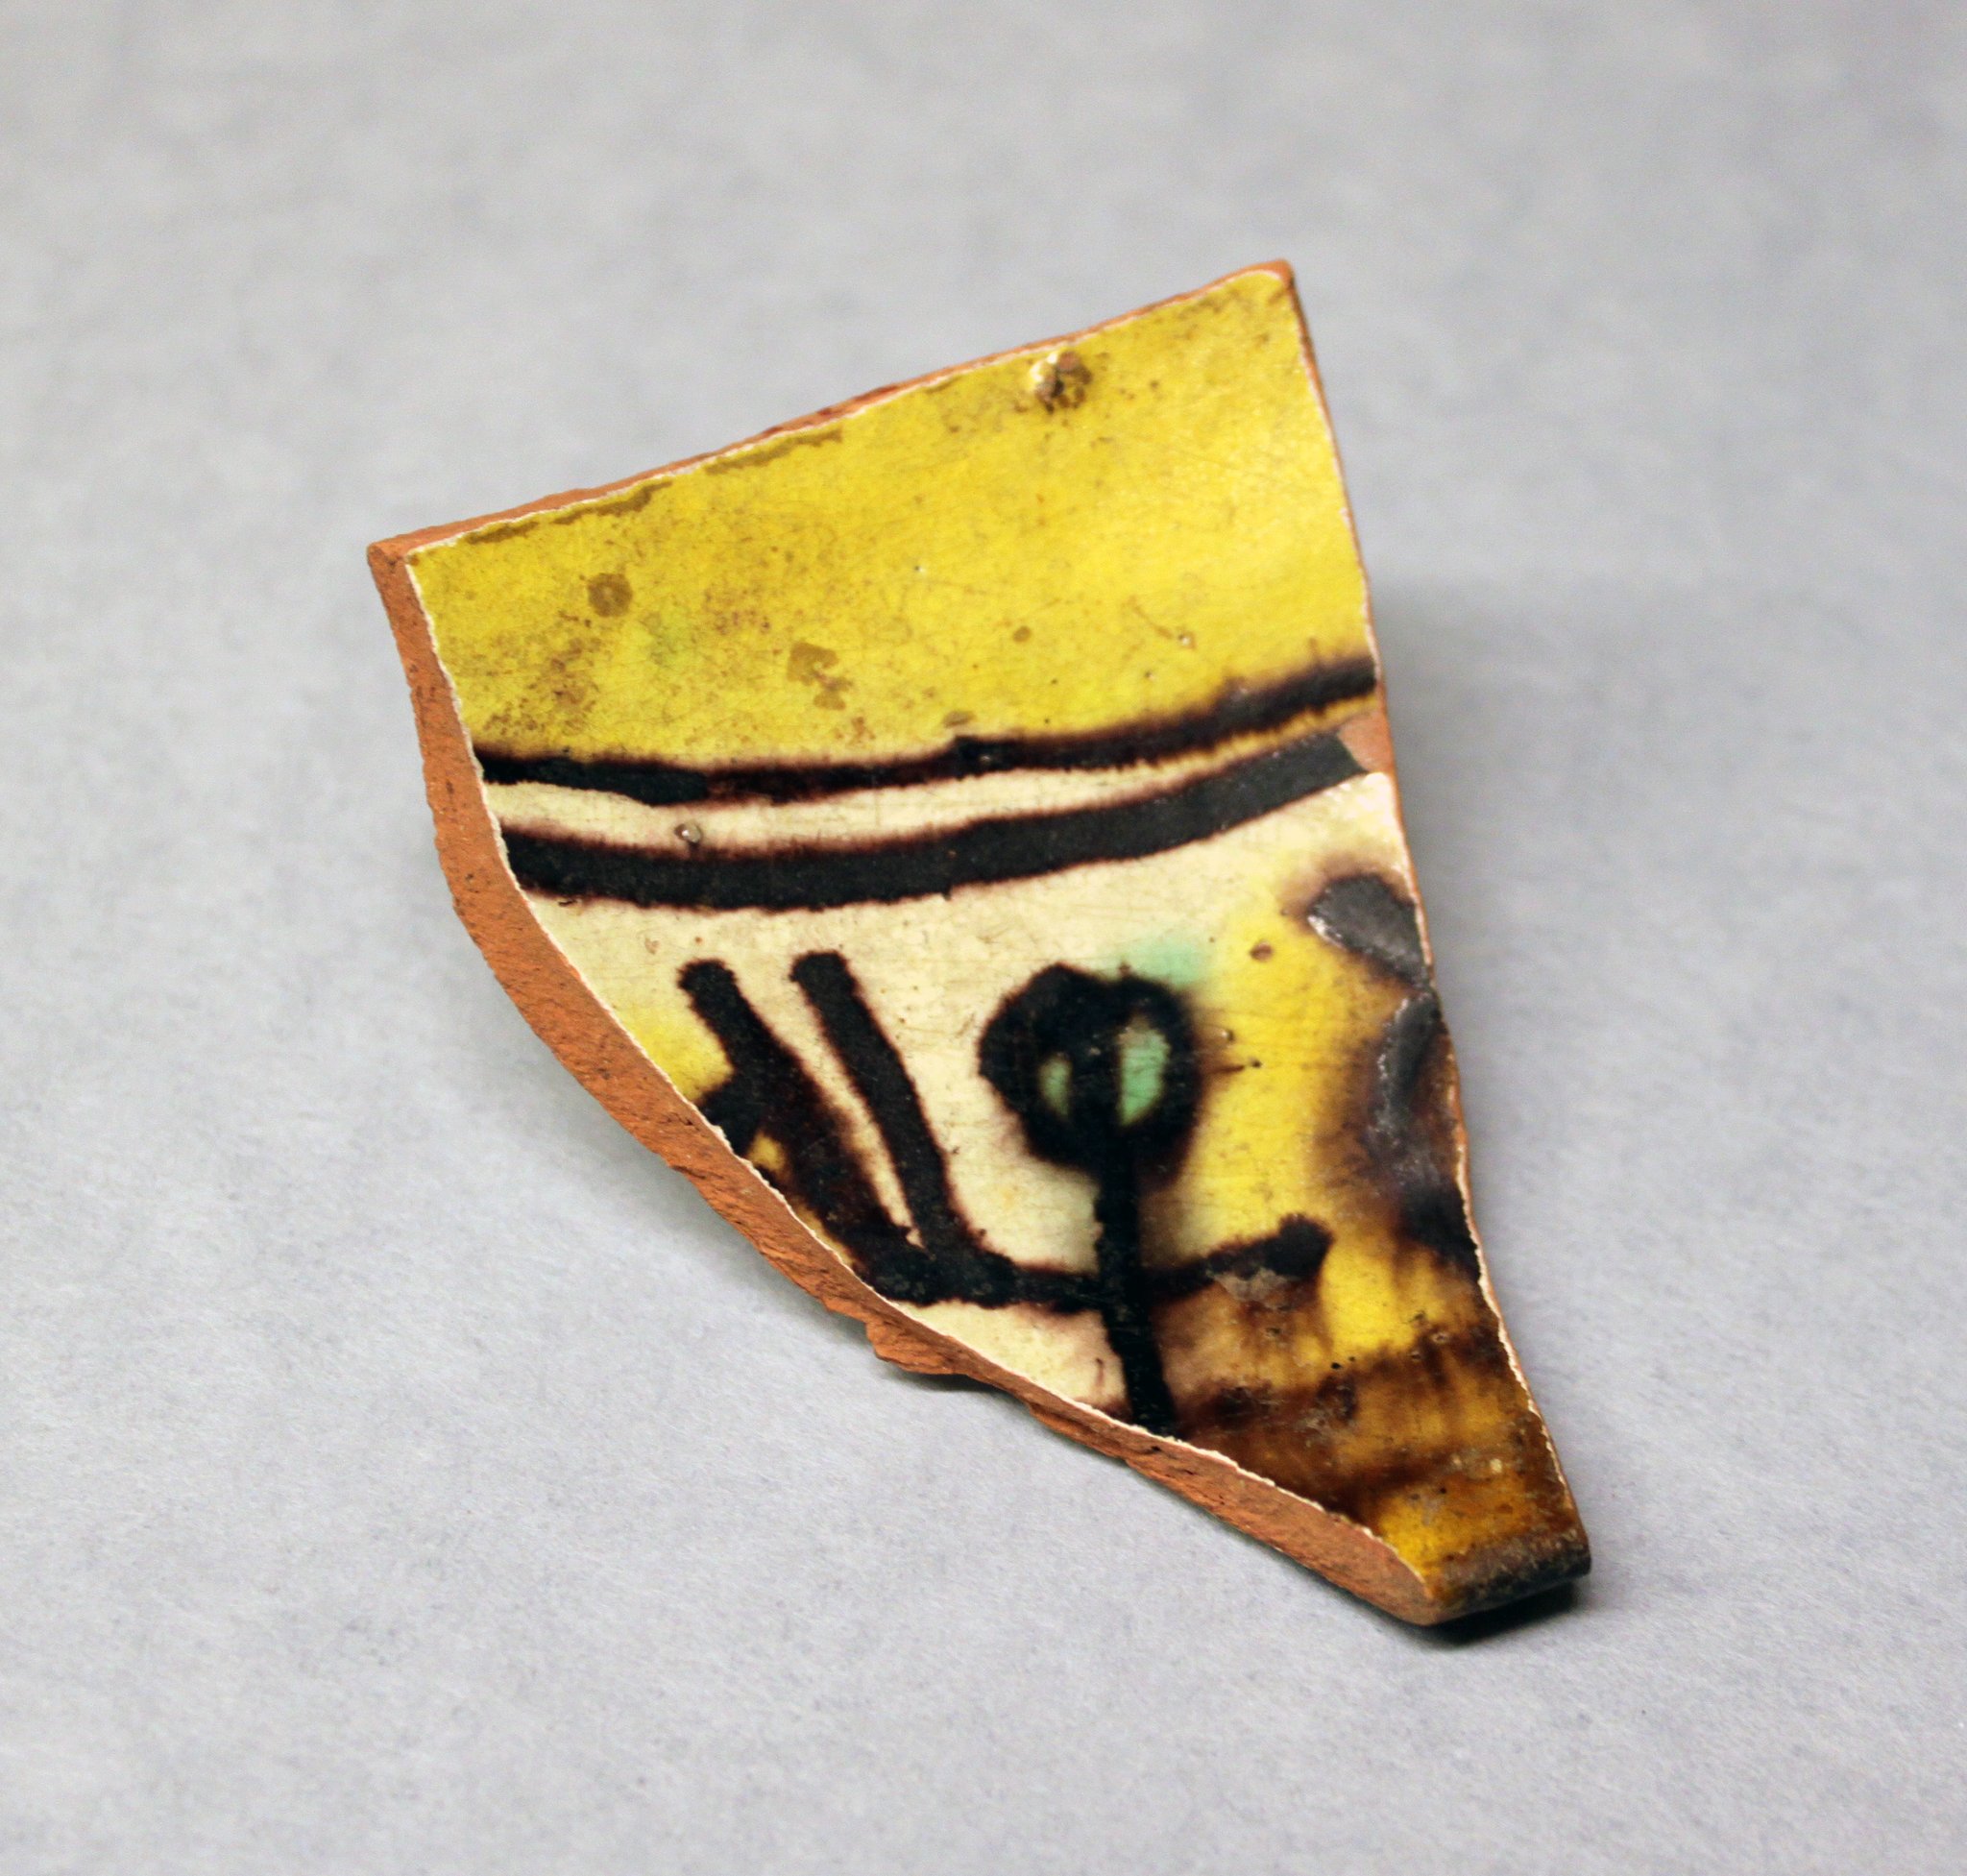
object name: fragment of a bowl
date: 801-1000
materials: earthenware, glaze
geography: iran